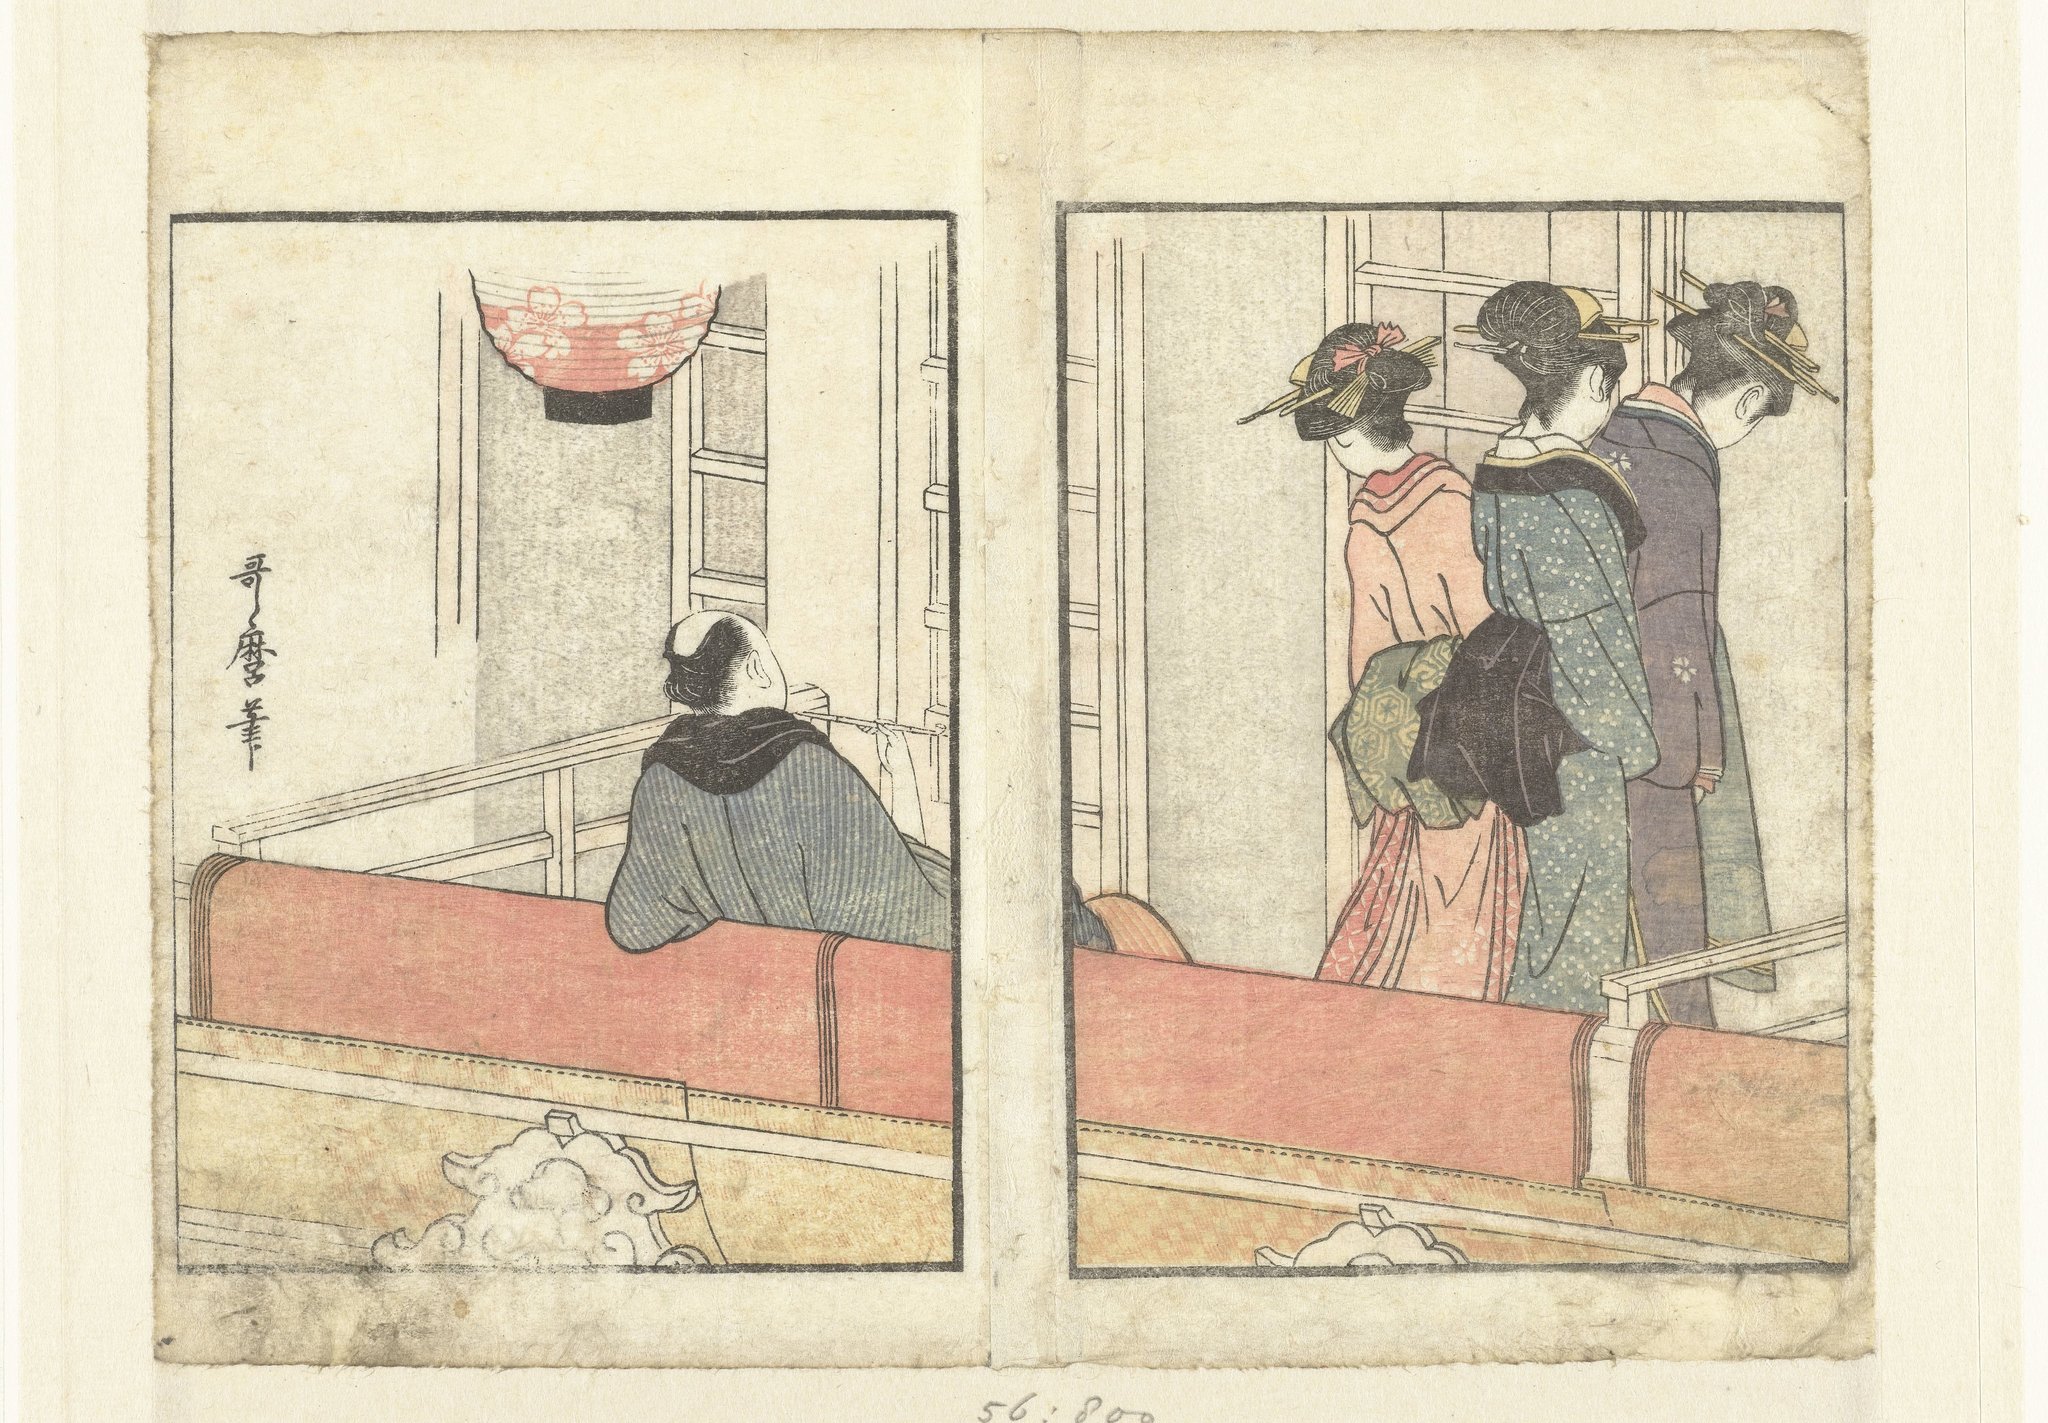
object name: print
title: Een kijkje achter de schermen bij de toneelspelers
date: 1799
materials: paper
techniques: woodcut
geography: edo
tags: boxes, loges ~ theatre, etc., adult man, adult woman (+ three persons)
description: Pijp rokende man, vanaf een bank kijkend naar drie dames die de loge verlaten; één van de drie zijdelings achter de coulissen kijkend. Twee bladen, aan elkaar geplakt, uit het Japanse boek Yakusha gakuya tsu.